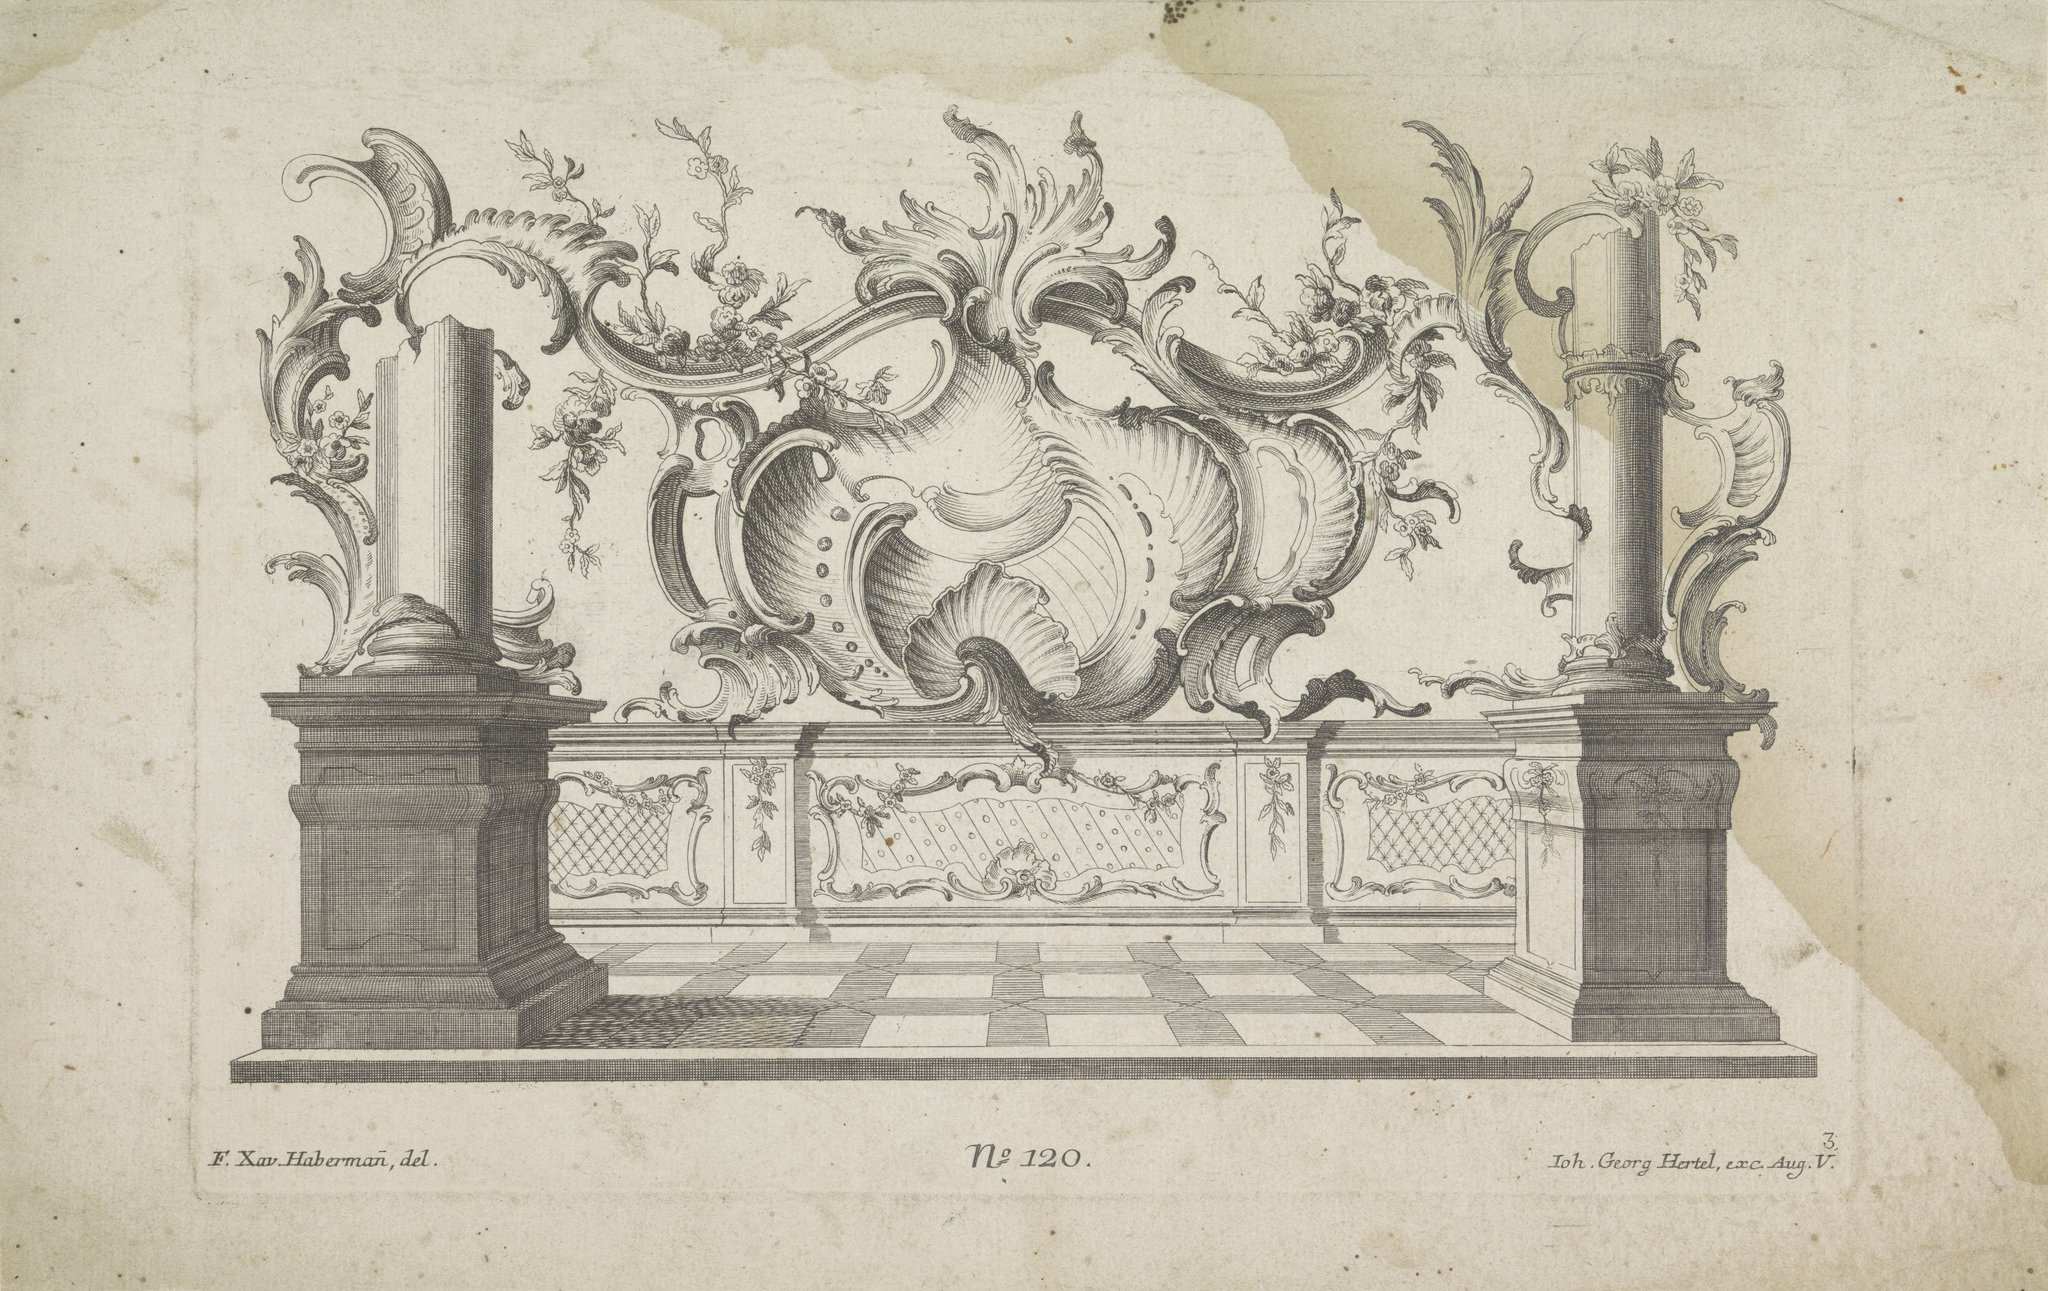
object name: ornament print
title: Rocaille-ornament met zuilen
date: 1731-1775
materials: paper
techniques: engraving, etching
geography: augsburg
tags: rocaille ornament, column, pillar ~ architecture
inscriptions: collector's mark: Lugt 2228, collector's mark: Lugt 2760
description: Rocaille ornament in interieur met aan weerszijden een zuil. Uitgeversnummer 120.